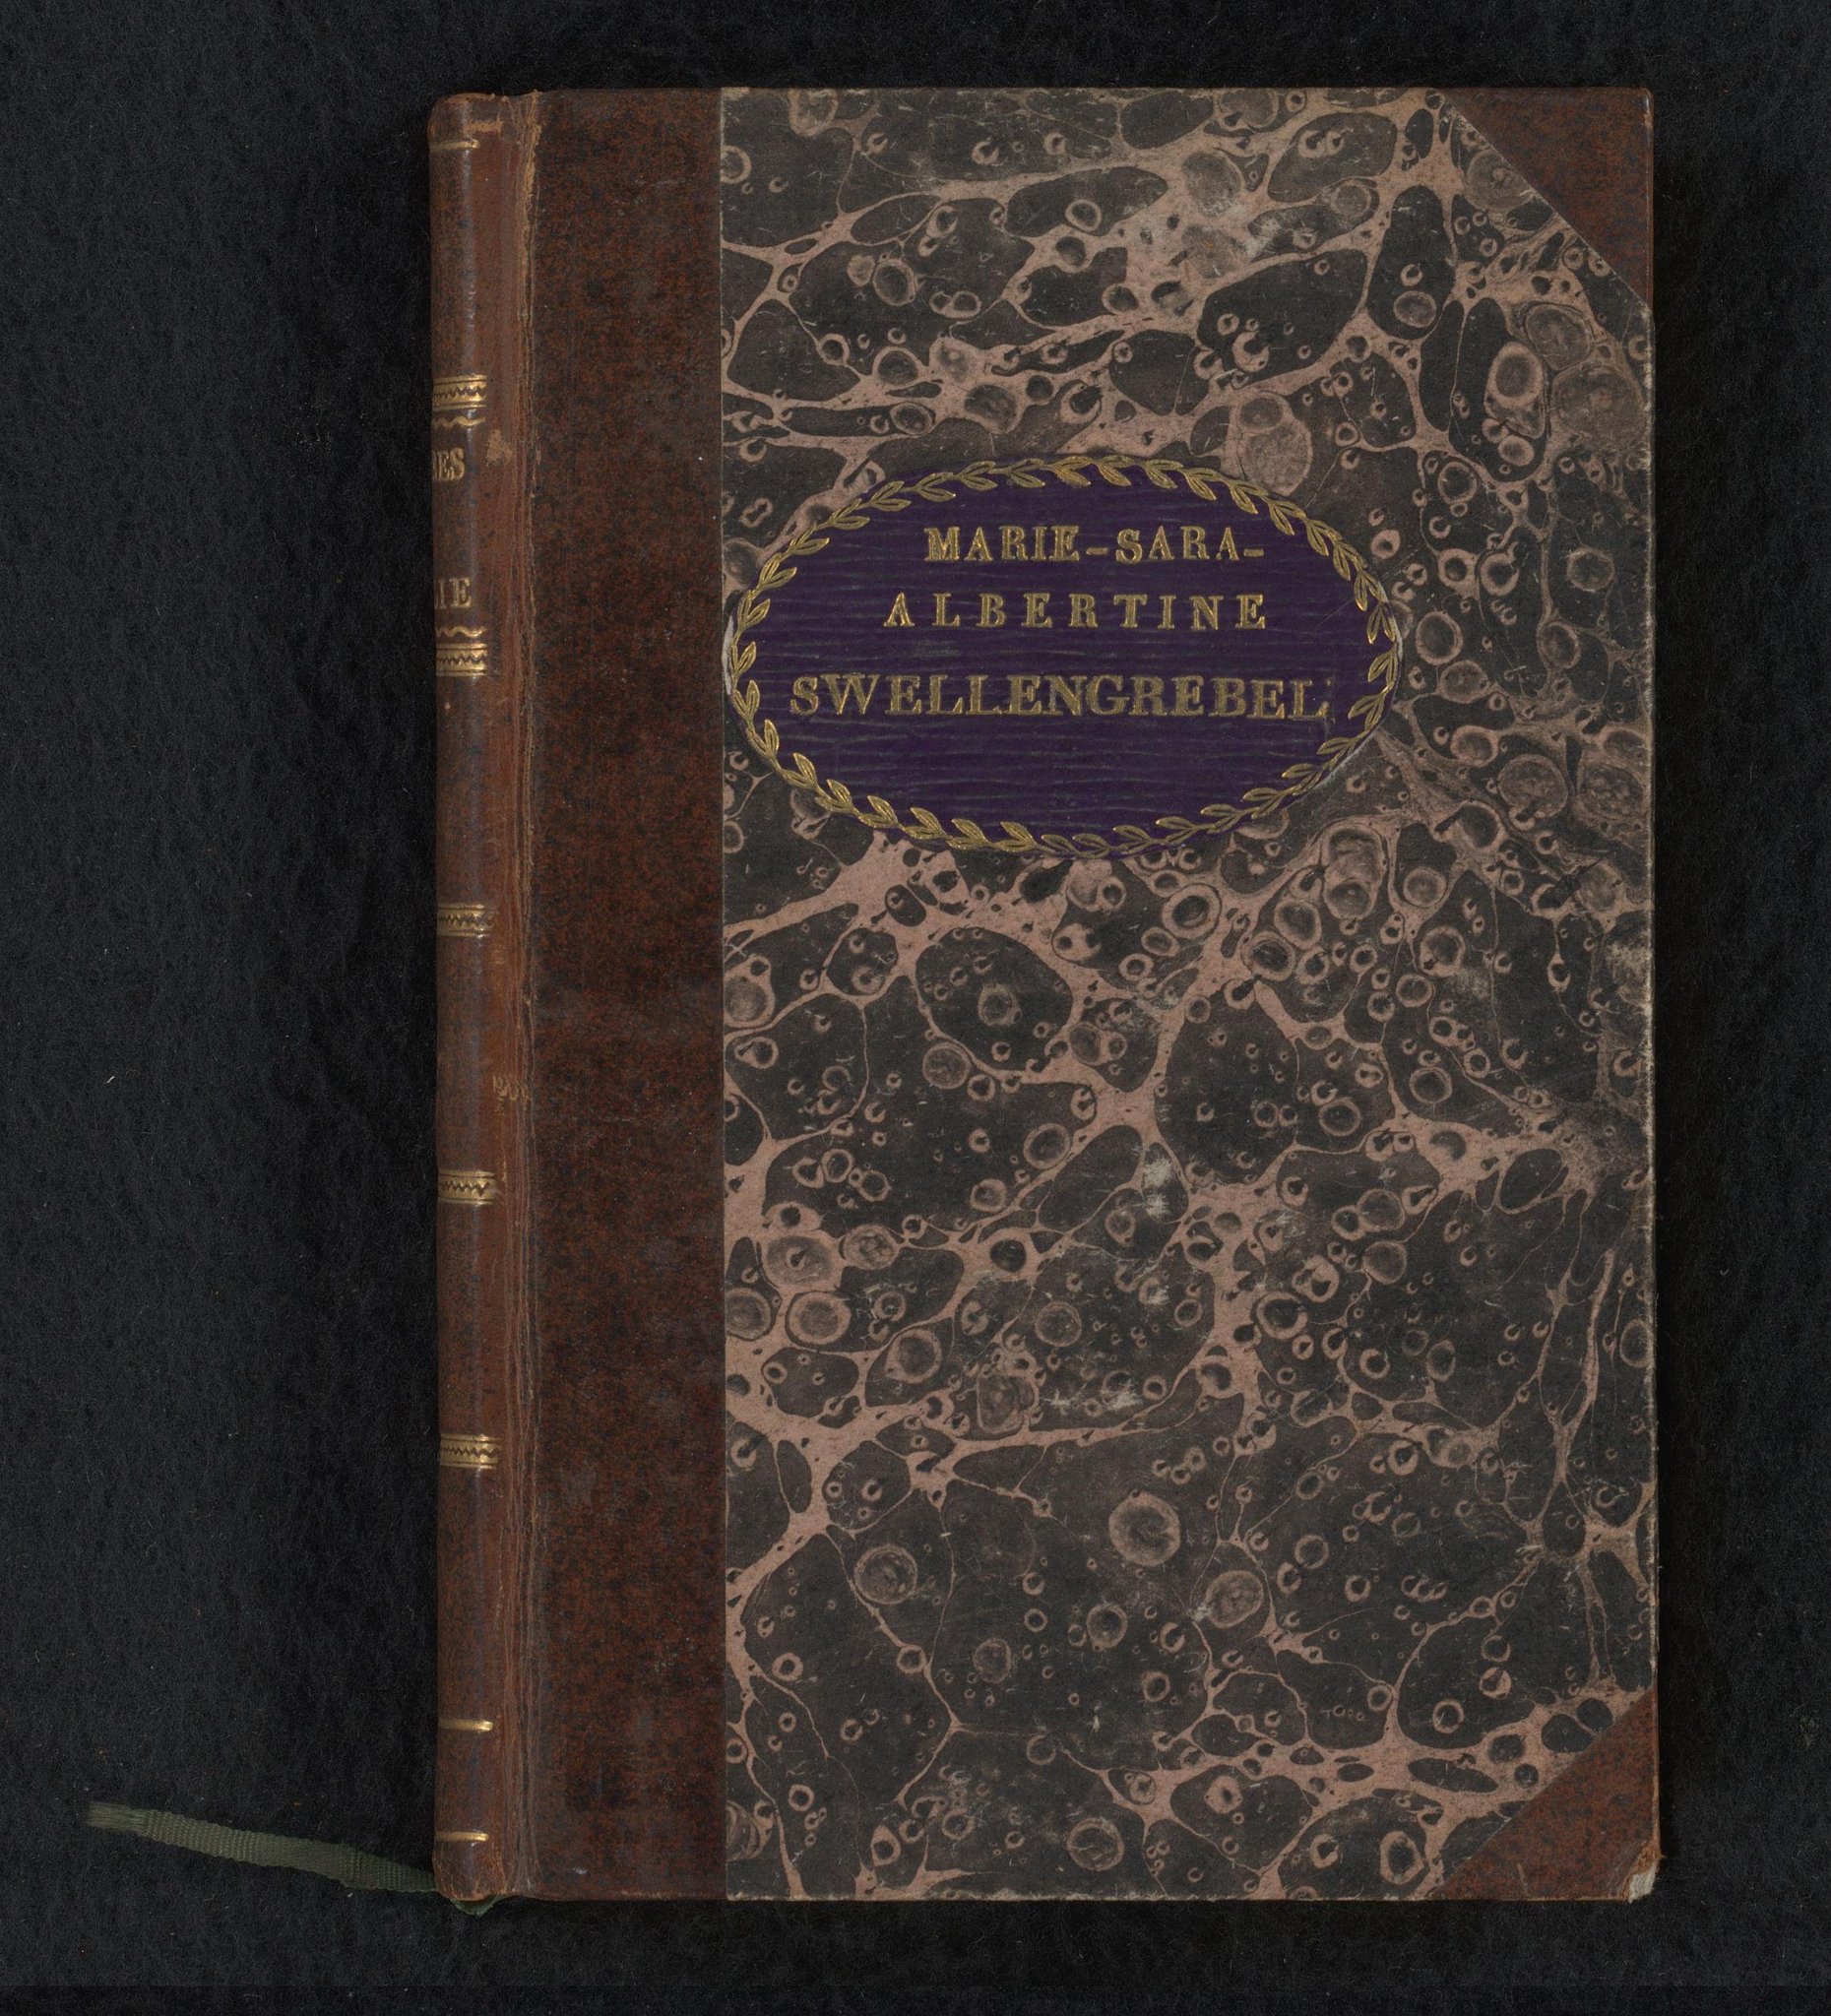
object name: book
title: Lettres a Émilie sur la Mythologie. Par C.A. Demoustier. Troisième partie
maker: antoine augustin renouard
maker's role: publisher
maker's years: 1765-1853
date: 1817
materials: leather, paper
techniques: letterpress printing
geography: paris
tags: maria sara albertina swellengrebel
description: Lettres a Émilie sur la Mythologie, dl. 3. Boek uit het bezit van Marie Sara Albertine Swellengrebel. Gebonden met de titel en deelnummer 2 op de rug en de naam van de eigenares in een ovaal vignet op de voorkant.